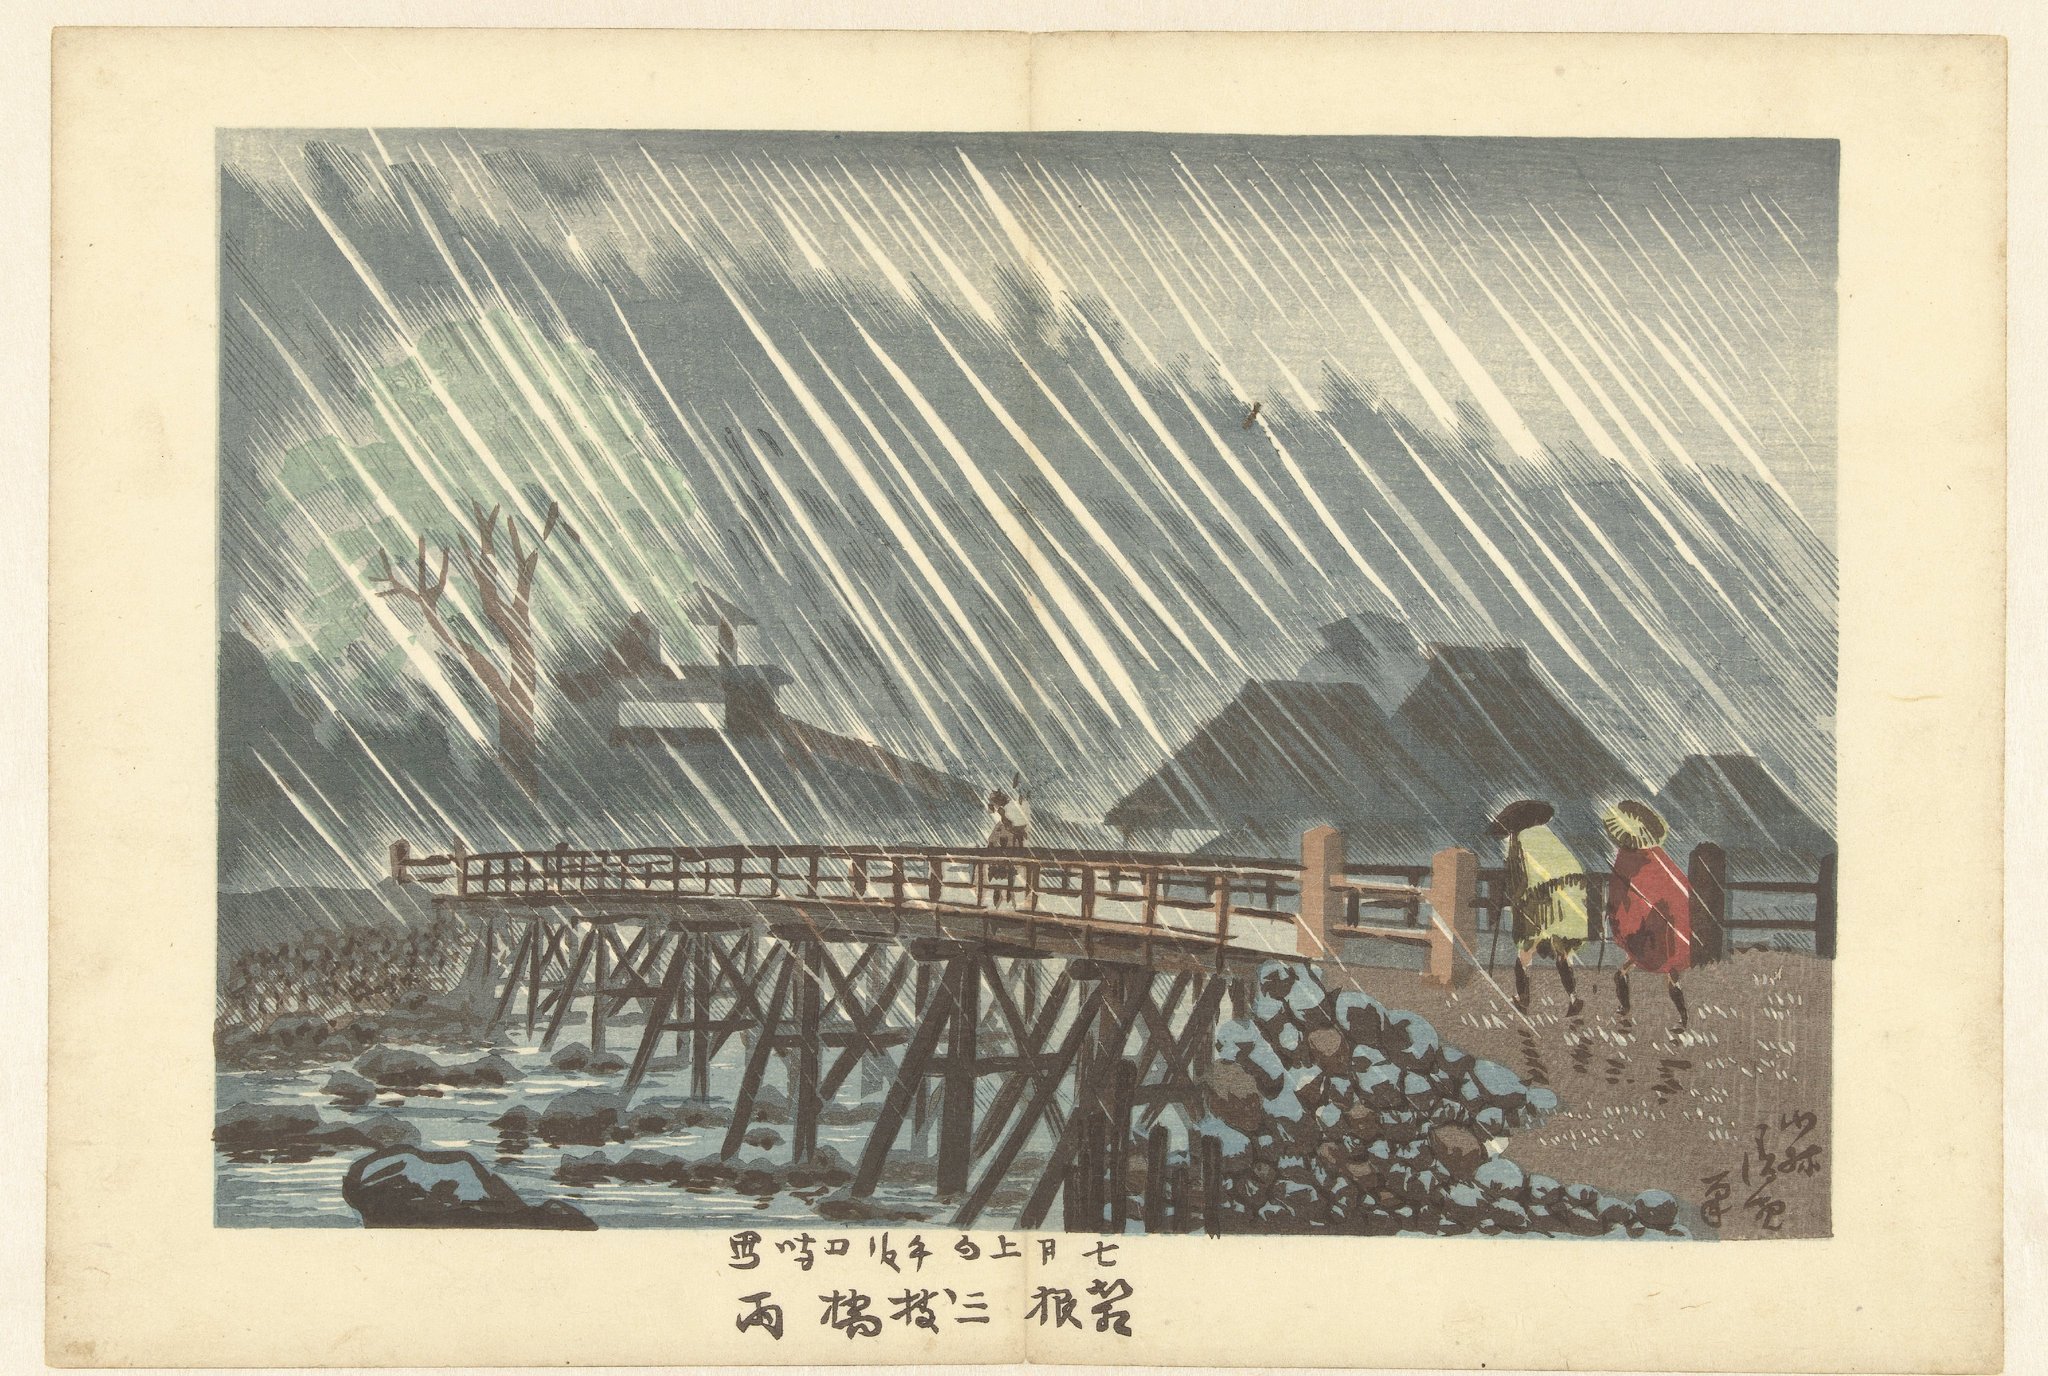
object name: print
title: Hakone Sanmaibashi ame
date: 1880-1882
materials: paper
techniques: woodcut, nishiki e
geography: tokyo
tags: rain, bridge, 'en route', traveller under way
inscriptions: collector's mark: Lugt 2228, collector's mark: Lugt 2760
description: De Sanmai brug met enkele reizigers tijdens zware regen; op de achtergrond een boom en verschillende huizen. Boven de titel staat vermeld wanneer de schets voor de prent gemaakt is: begin juli om vier uur s`middags.